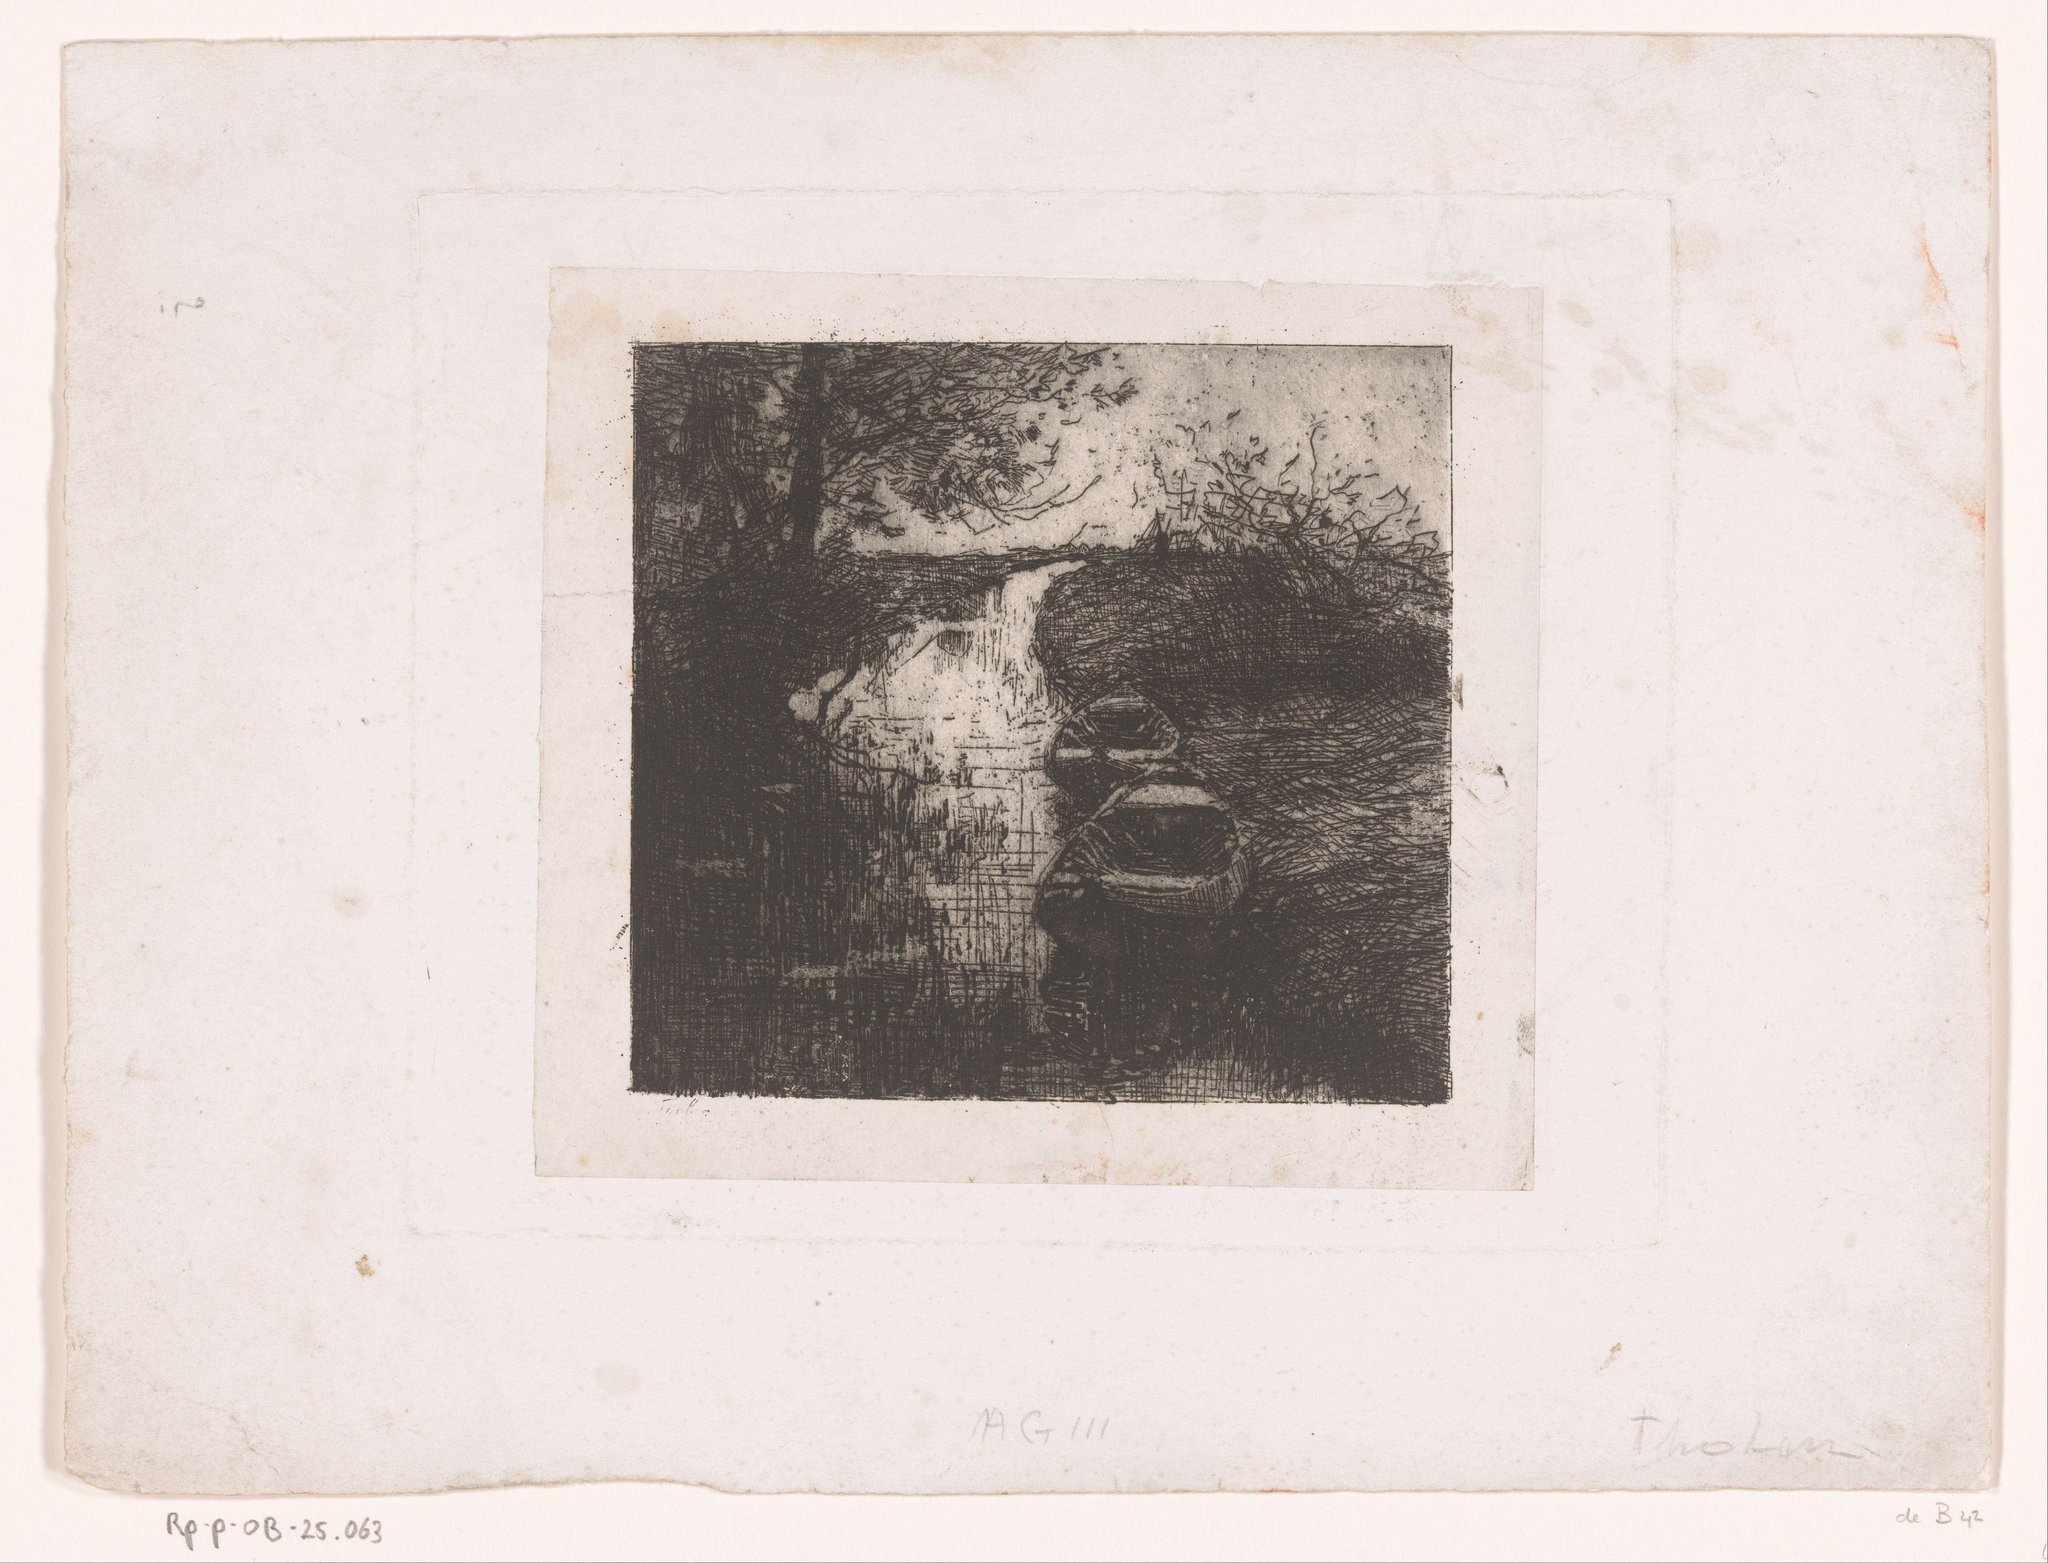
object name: print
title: Sloot in de avond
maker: willem bastiaan tholen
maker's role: draughtsman, painter, print maker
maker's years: 1860-1931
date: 1870-1931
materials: paper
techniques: etching, intaglio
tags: rowing-boat, canoe, etc., small canal, ditch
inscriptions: collector's mark: Lugt 2228